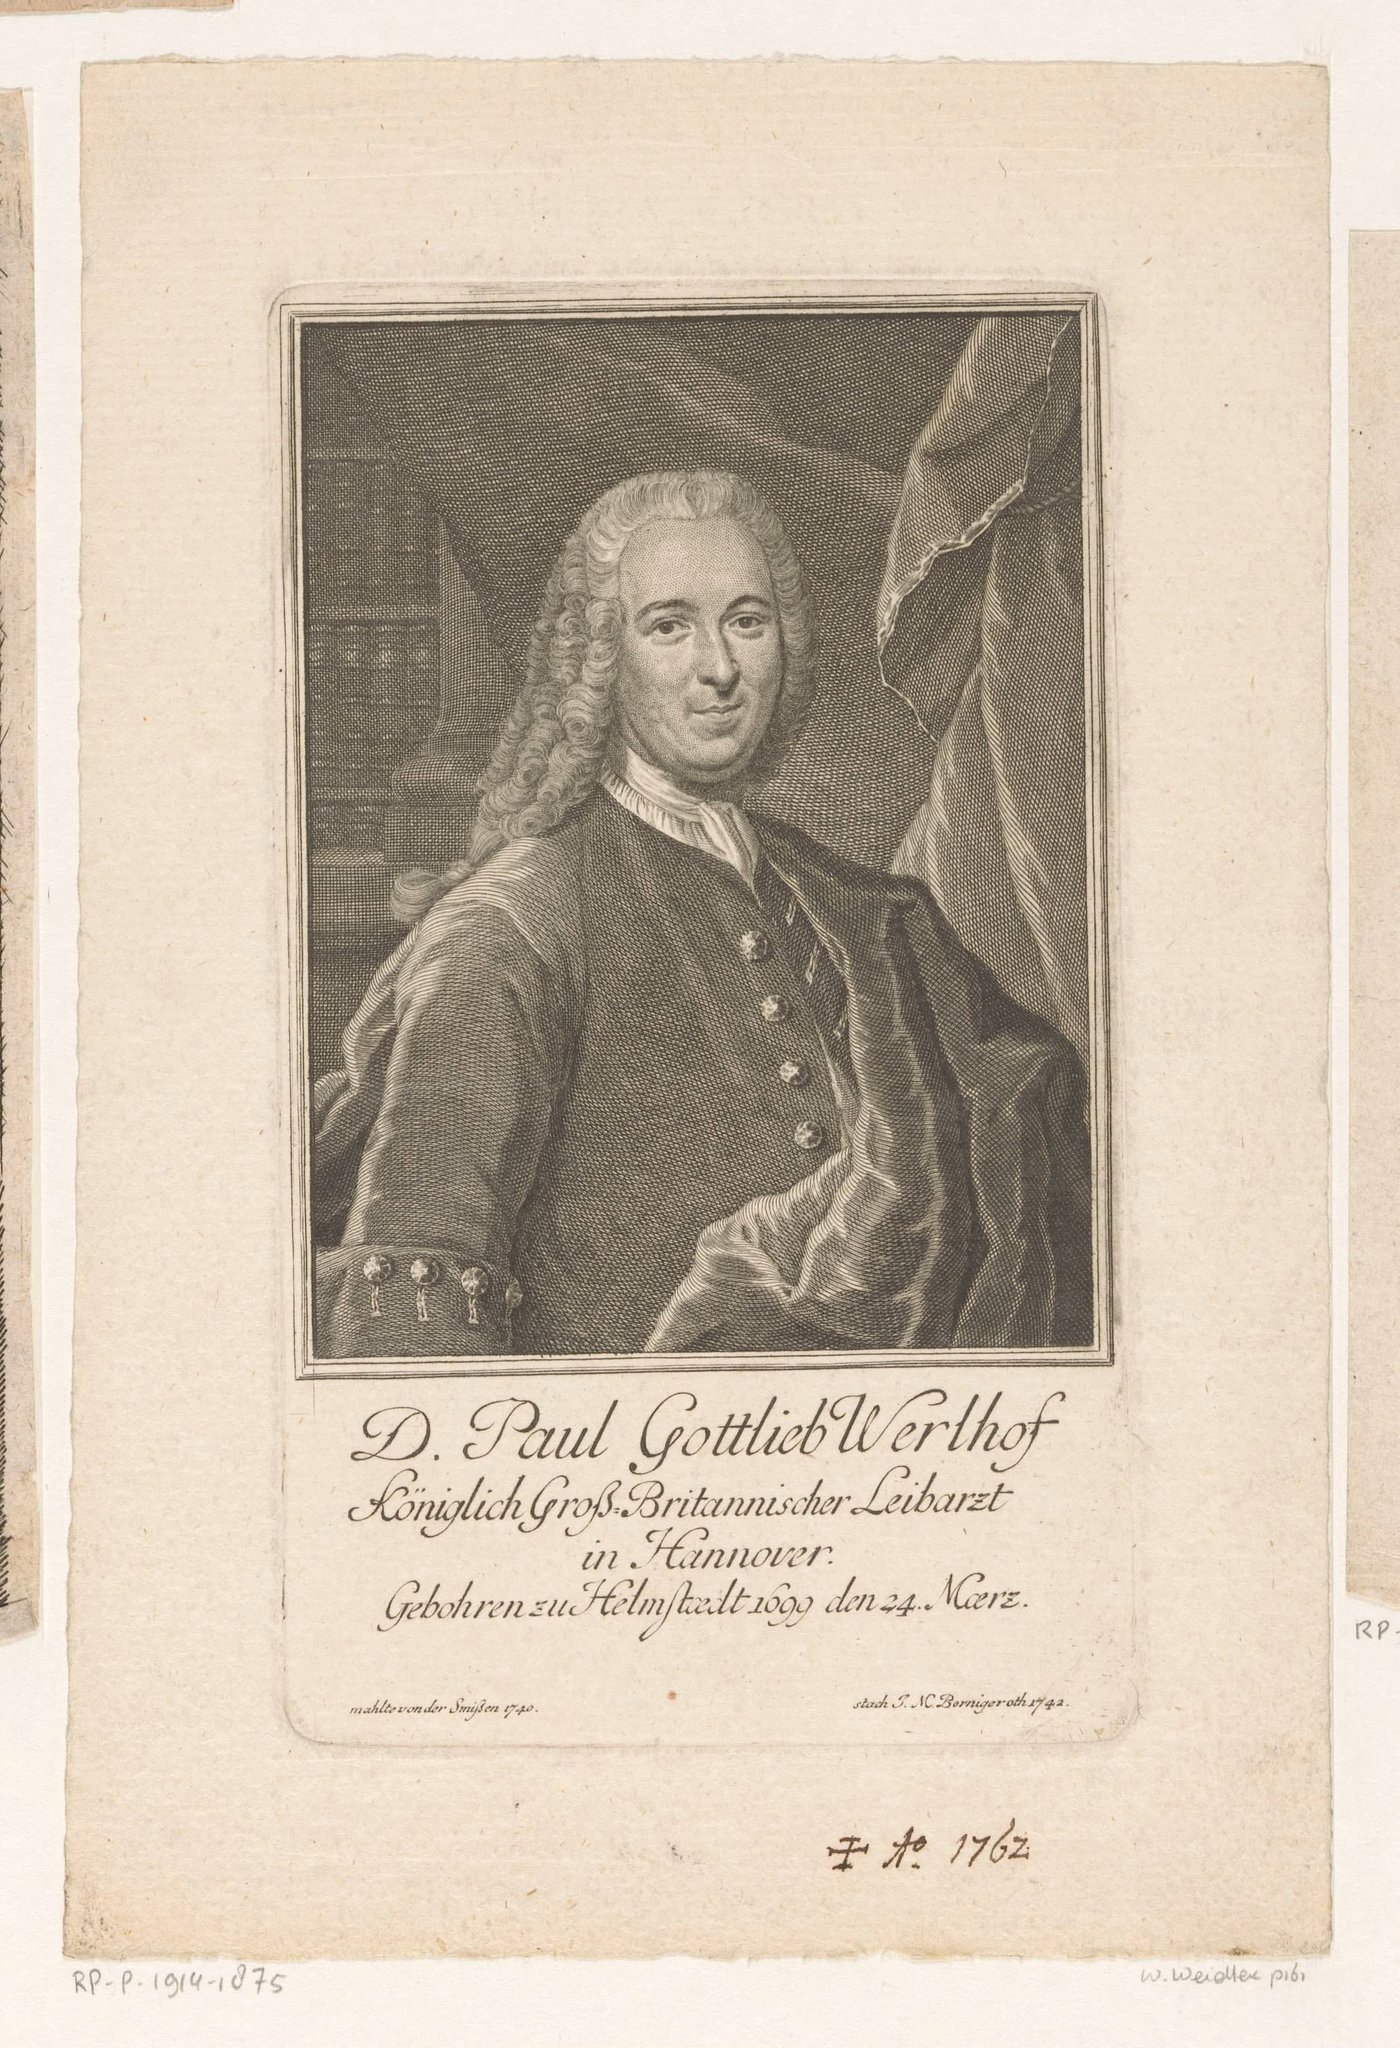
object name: print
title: Portret van Paul Gottlieb Werlhof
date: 1742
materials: paper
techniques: engraving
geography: leipzig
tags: paul gottlieb werlhof, bookshelves, historical persons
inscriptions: collector's mark: Lugt 2228